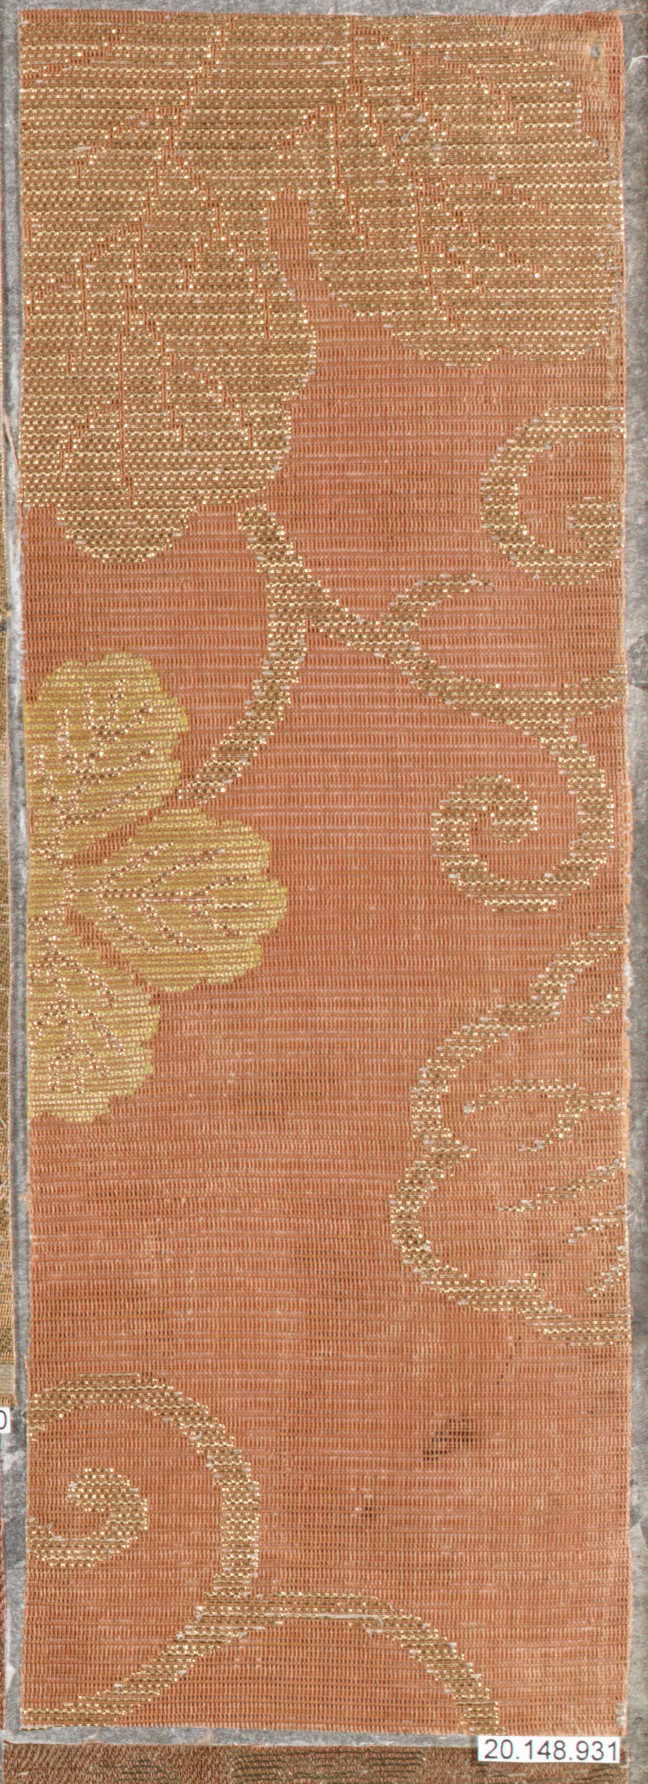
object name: piece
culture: japanese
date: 1701-1800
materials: silk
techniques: compound weave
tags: flowers